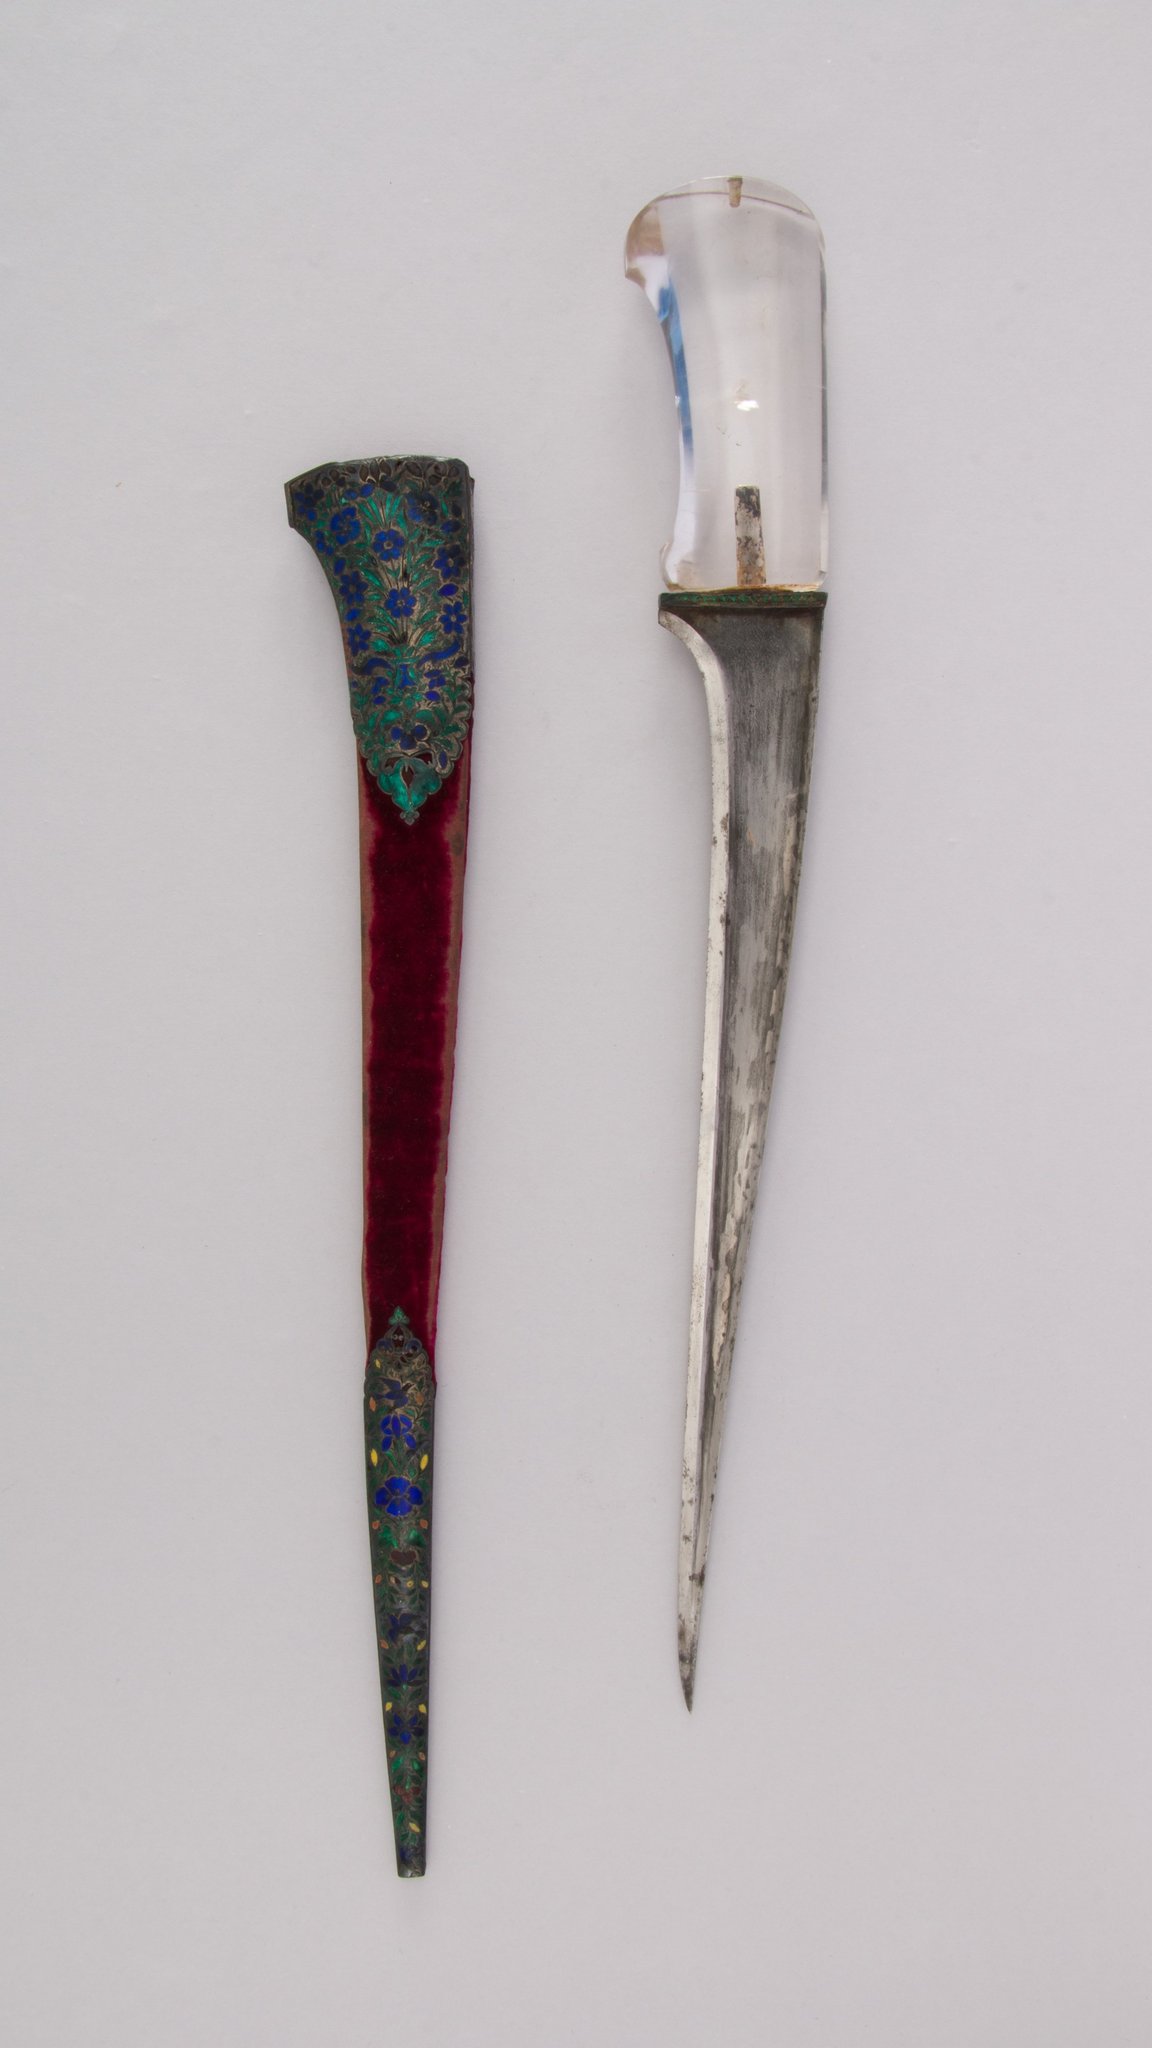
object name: dagger pesh kabz with sheath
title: Dagger (Pesh-kabz) with Sheath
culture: indian, mughal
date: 1701-1900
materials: enamel, quartz, silver, steel, velvet, wood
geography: india